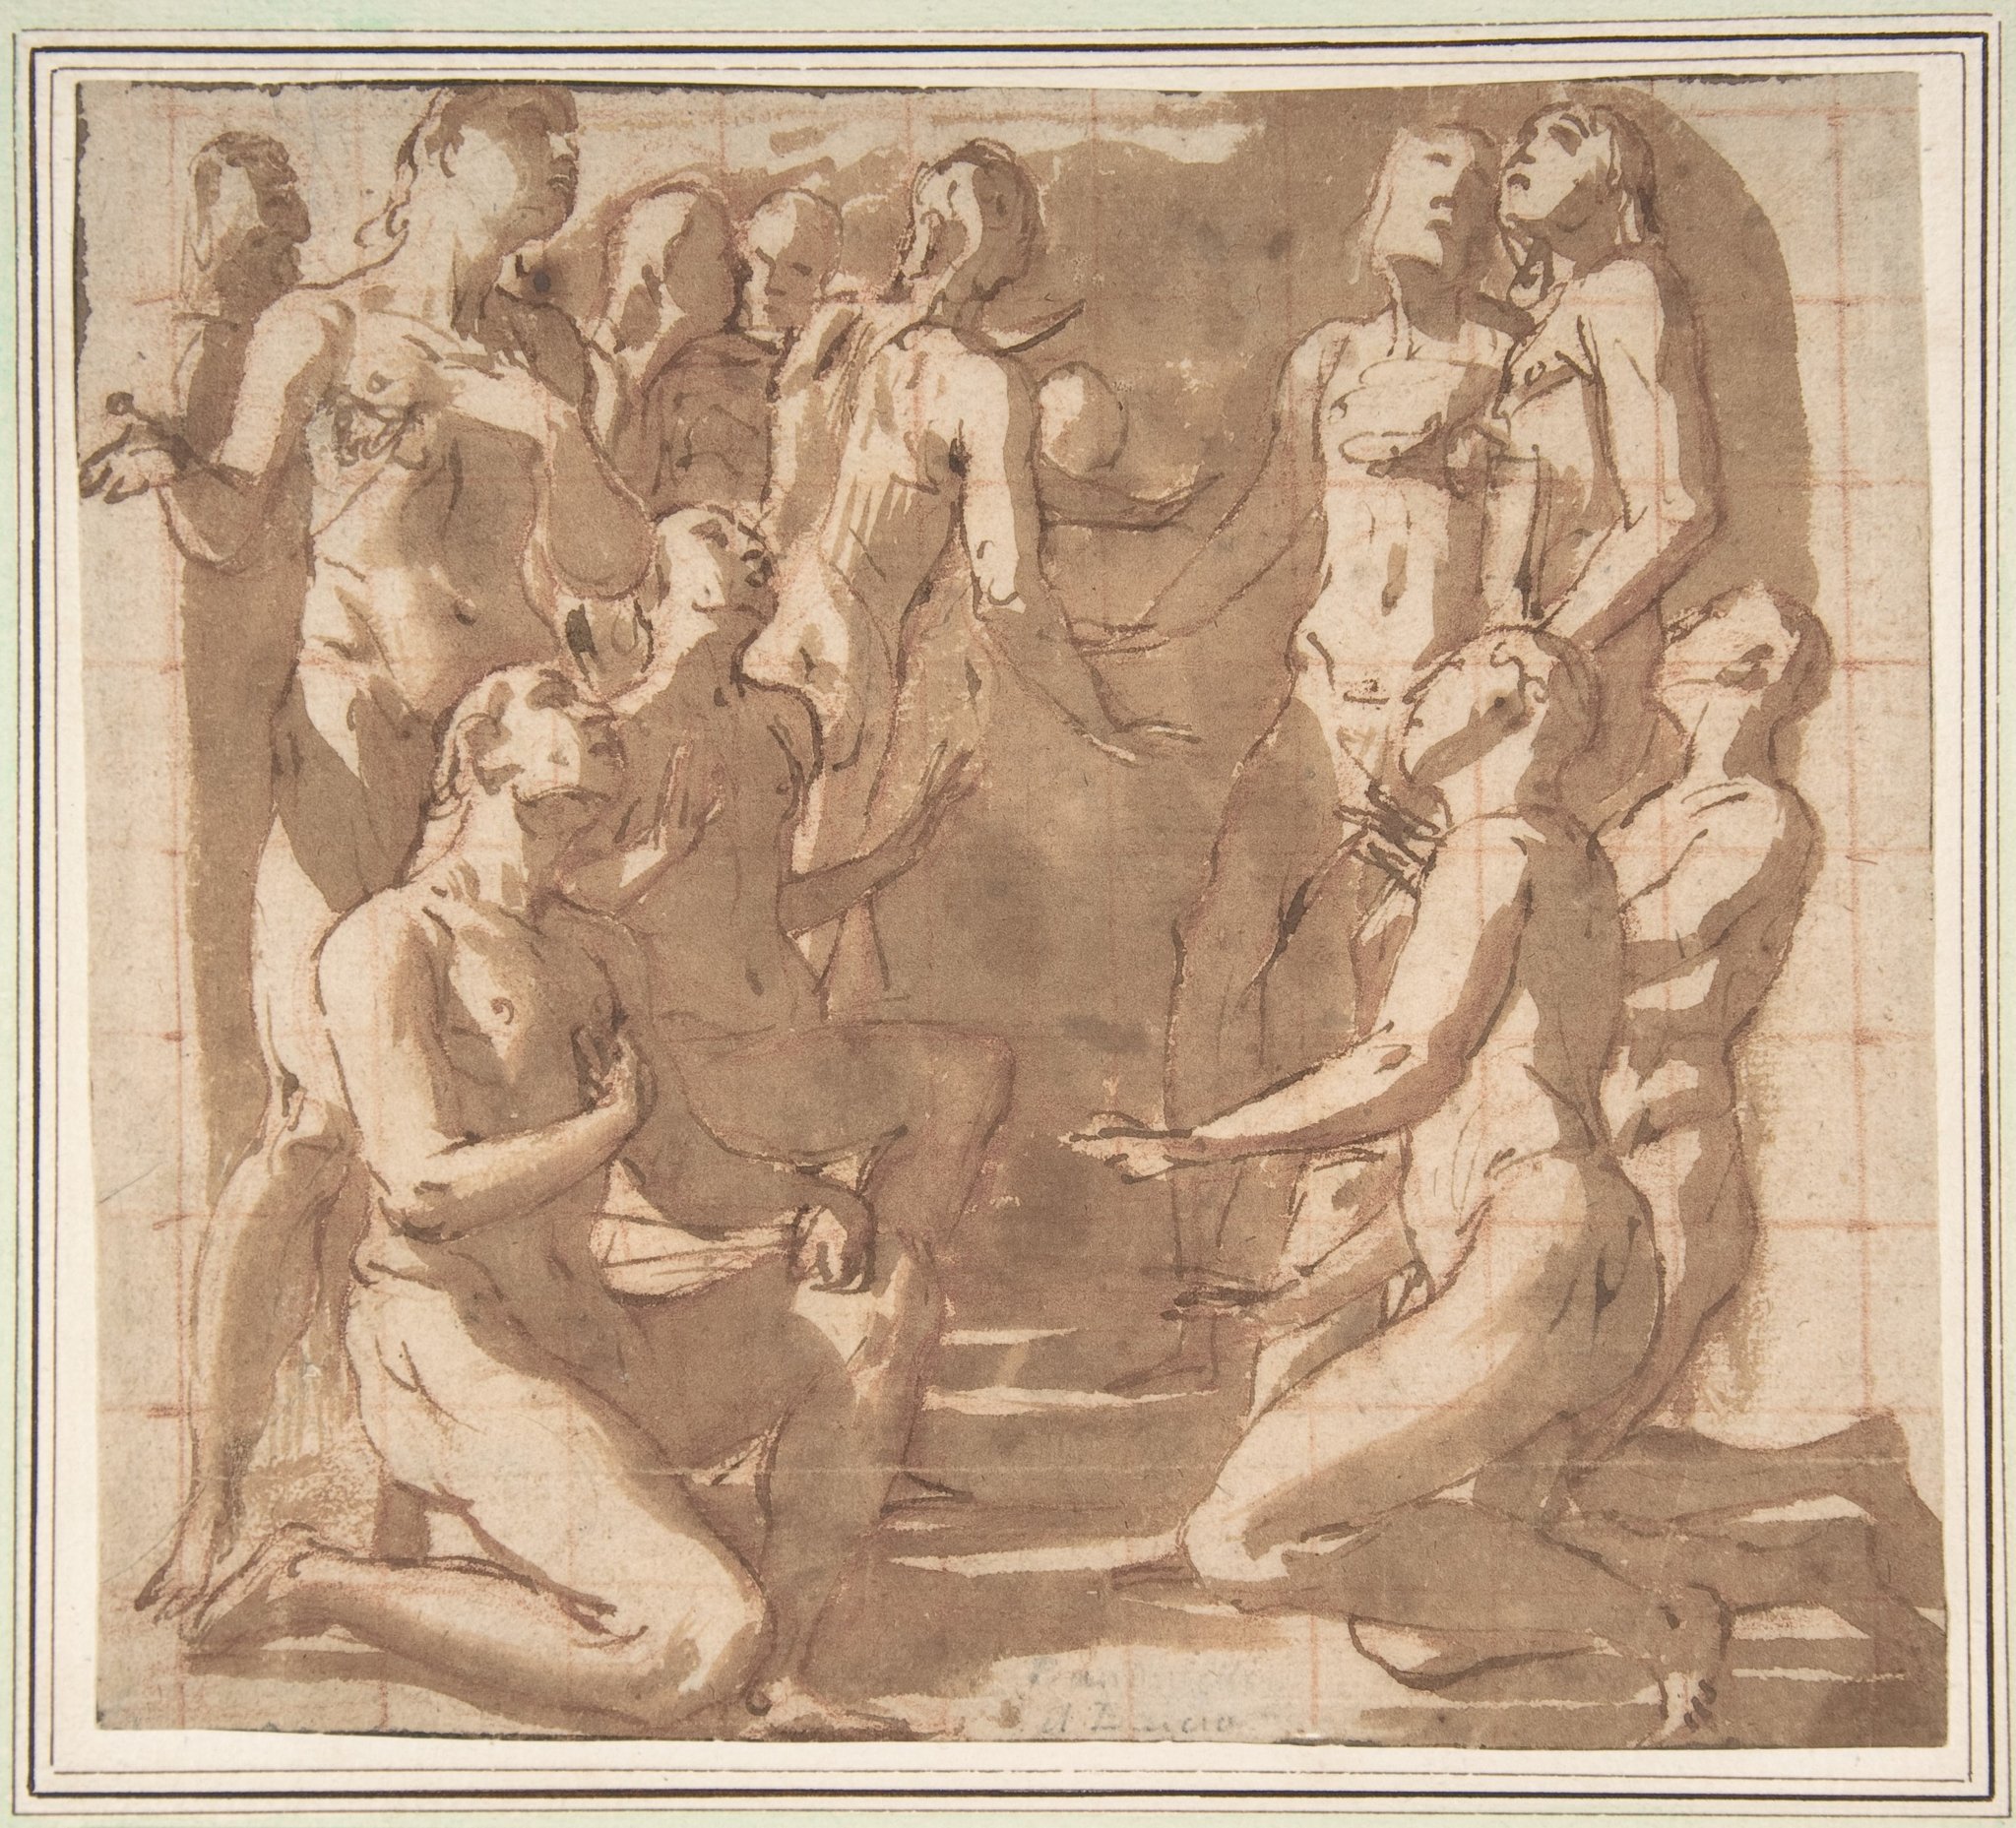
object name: drawing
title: Group of Nude Male Figures Kneeling and Standing in Supplication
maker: giovanni baglione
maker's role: artist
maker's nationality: italian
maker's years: 1566-1643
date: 1598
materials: chalk, ink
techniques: brush, pen, drawing, wash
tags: male nudes